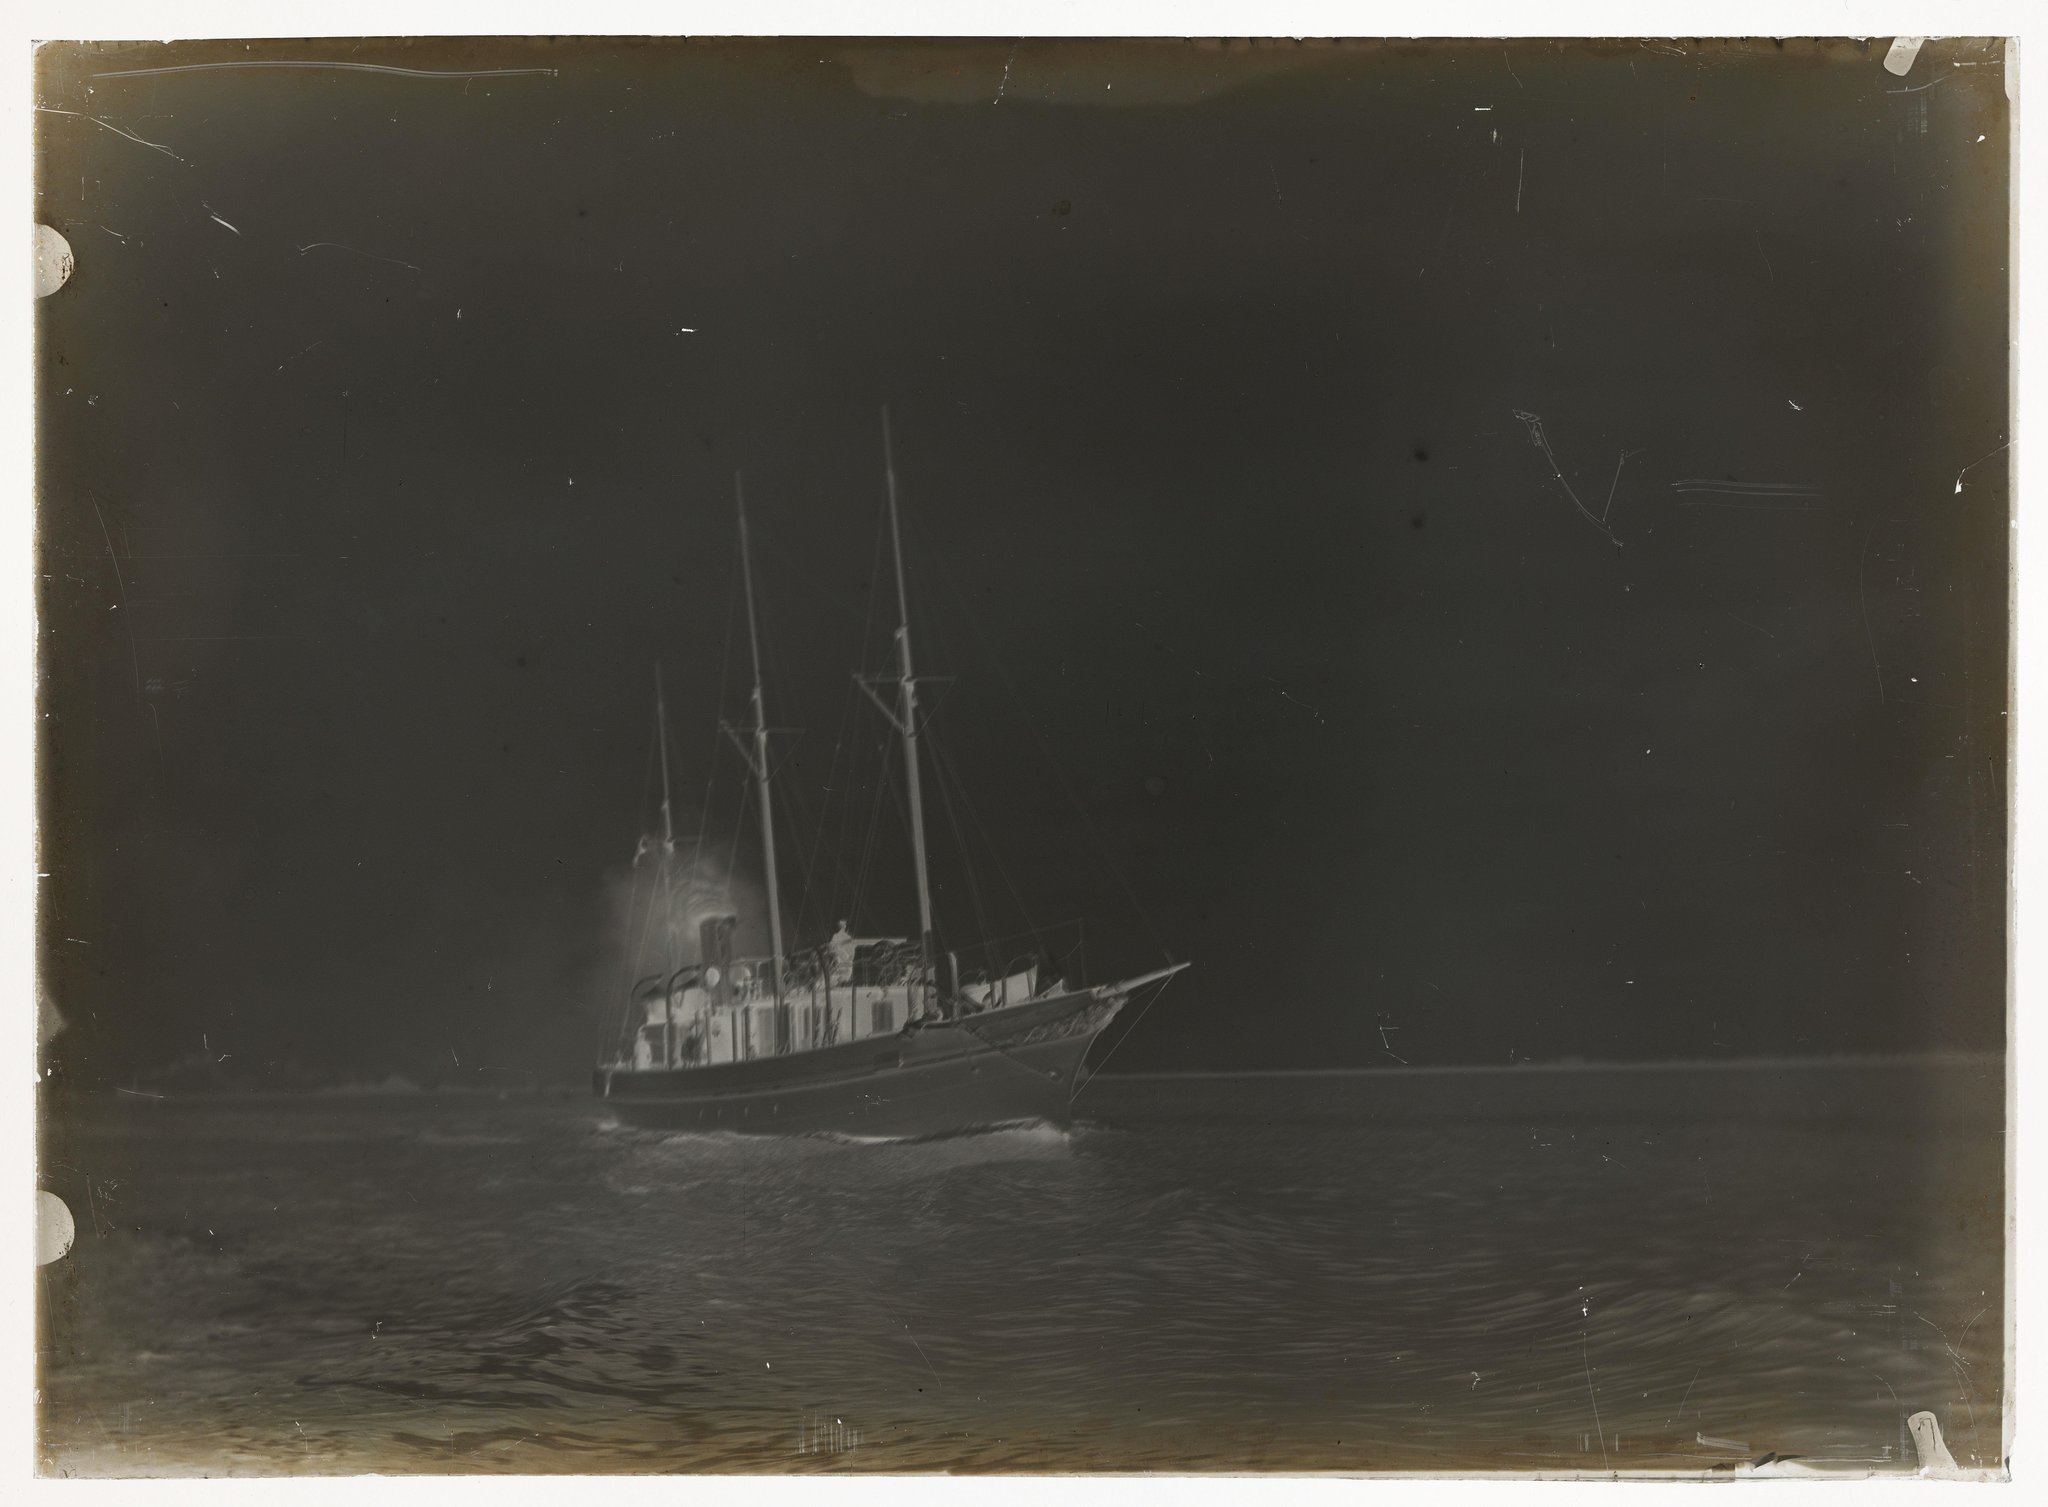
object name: glasnegatief, glasplaatnegatief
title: Stoomschip te water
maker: machiel gerrit george suyver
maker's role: fotograaf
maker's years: 1872-1933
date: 1890-1898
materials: glass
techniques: gelatin glass negative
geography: netherlands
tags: steamship, motorship